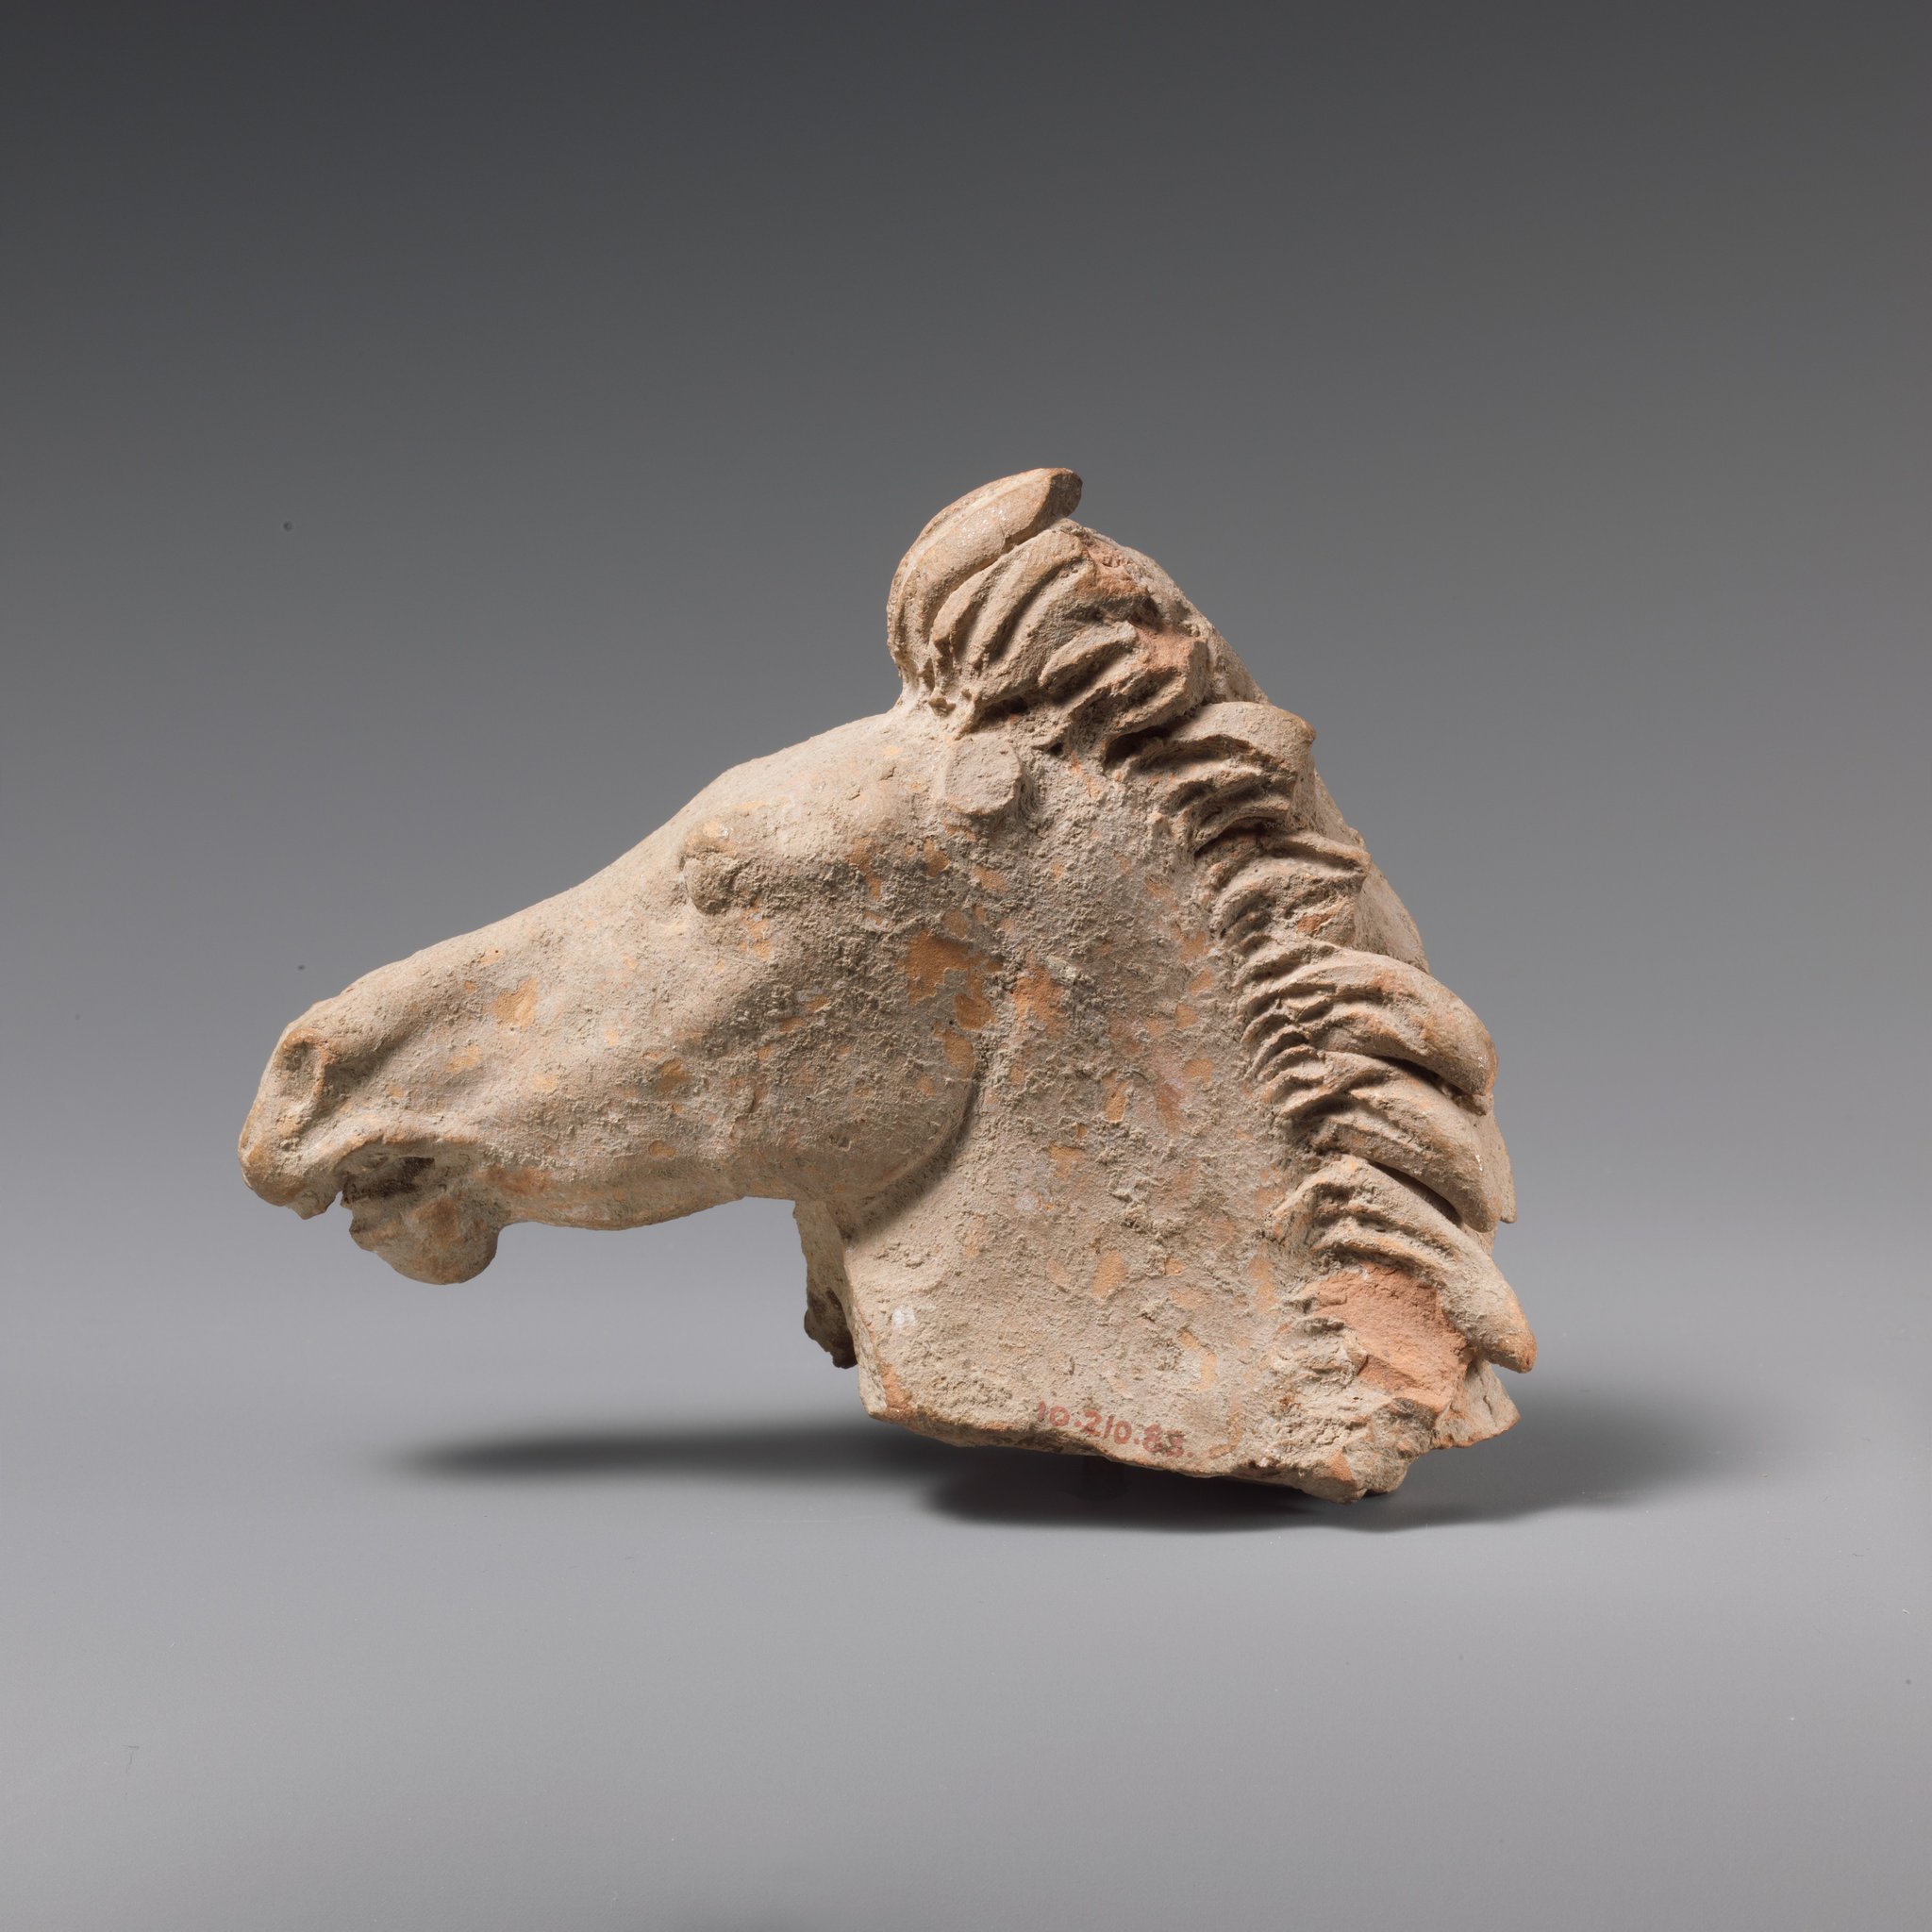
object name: statuette of a horse's head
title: Terracotta horse's head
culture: greek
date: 300-201 BCE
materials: terracotta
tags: horses